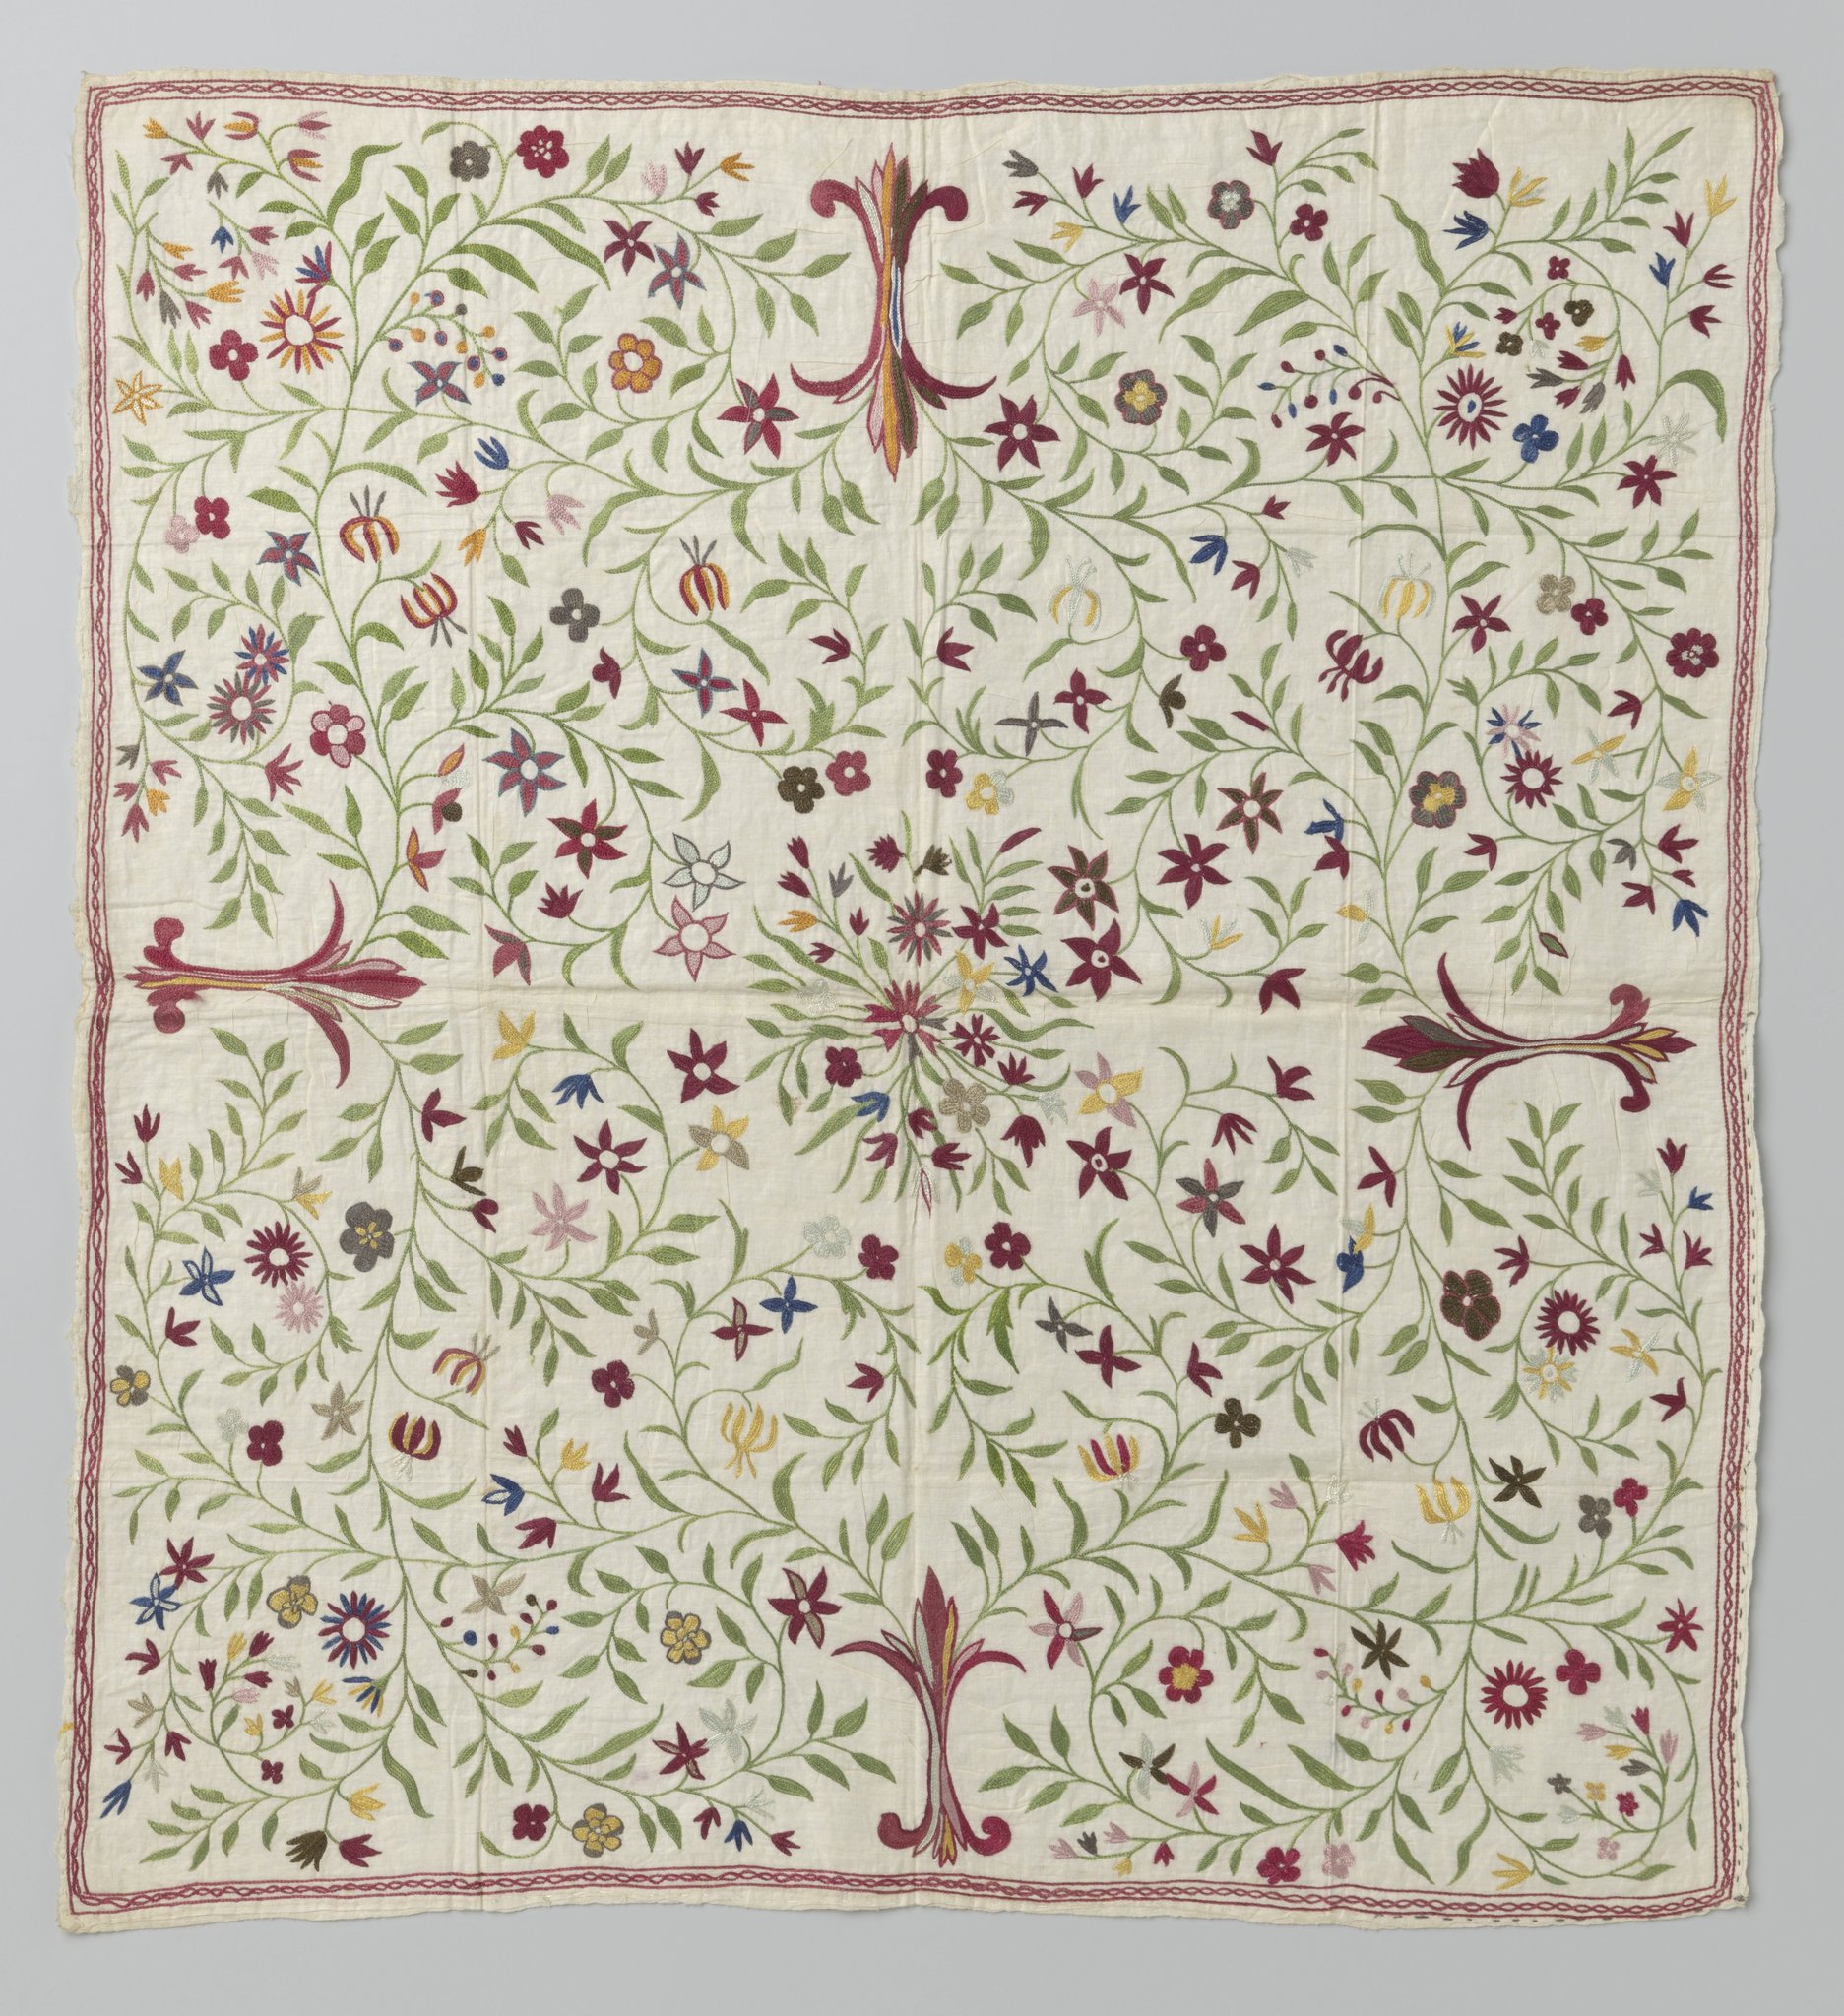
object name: textile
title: Kleed van oosterse textiel met veelkleurig borduurwerk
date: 1800-1899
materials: cotton, silk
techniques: embroidered, weave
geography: east indies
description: Kleed van veelkleurig getamboereerde katoen, versierd met bloemranken en ornament, gevoerd met katoen.